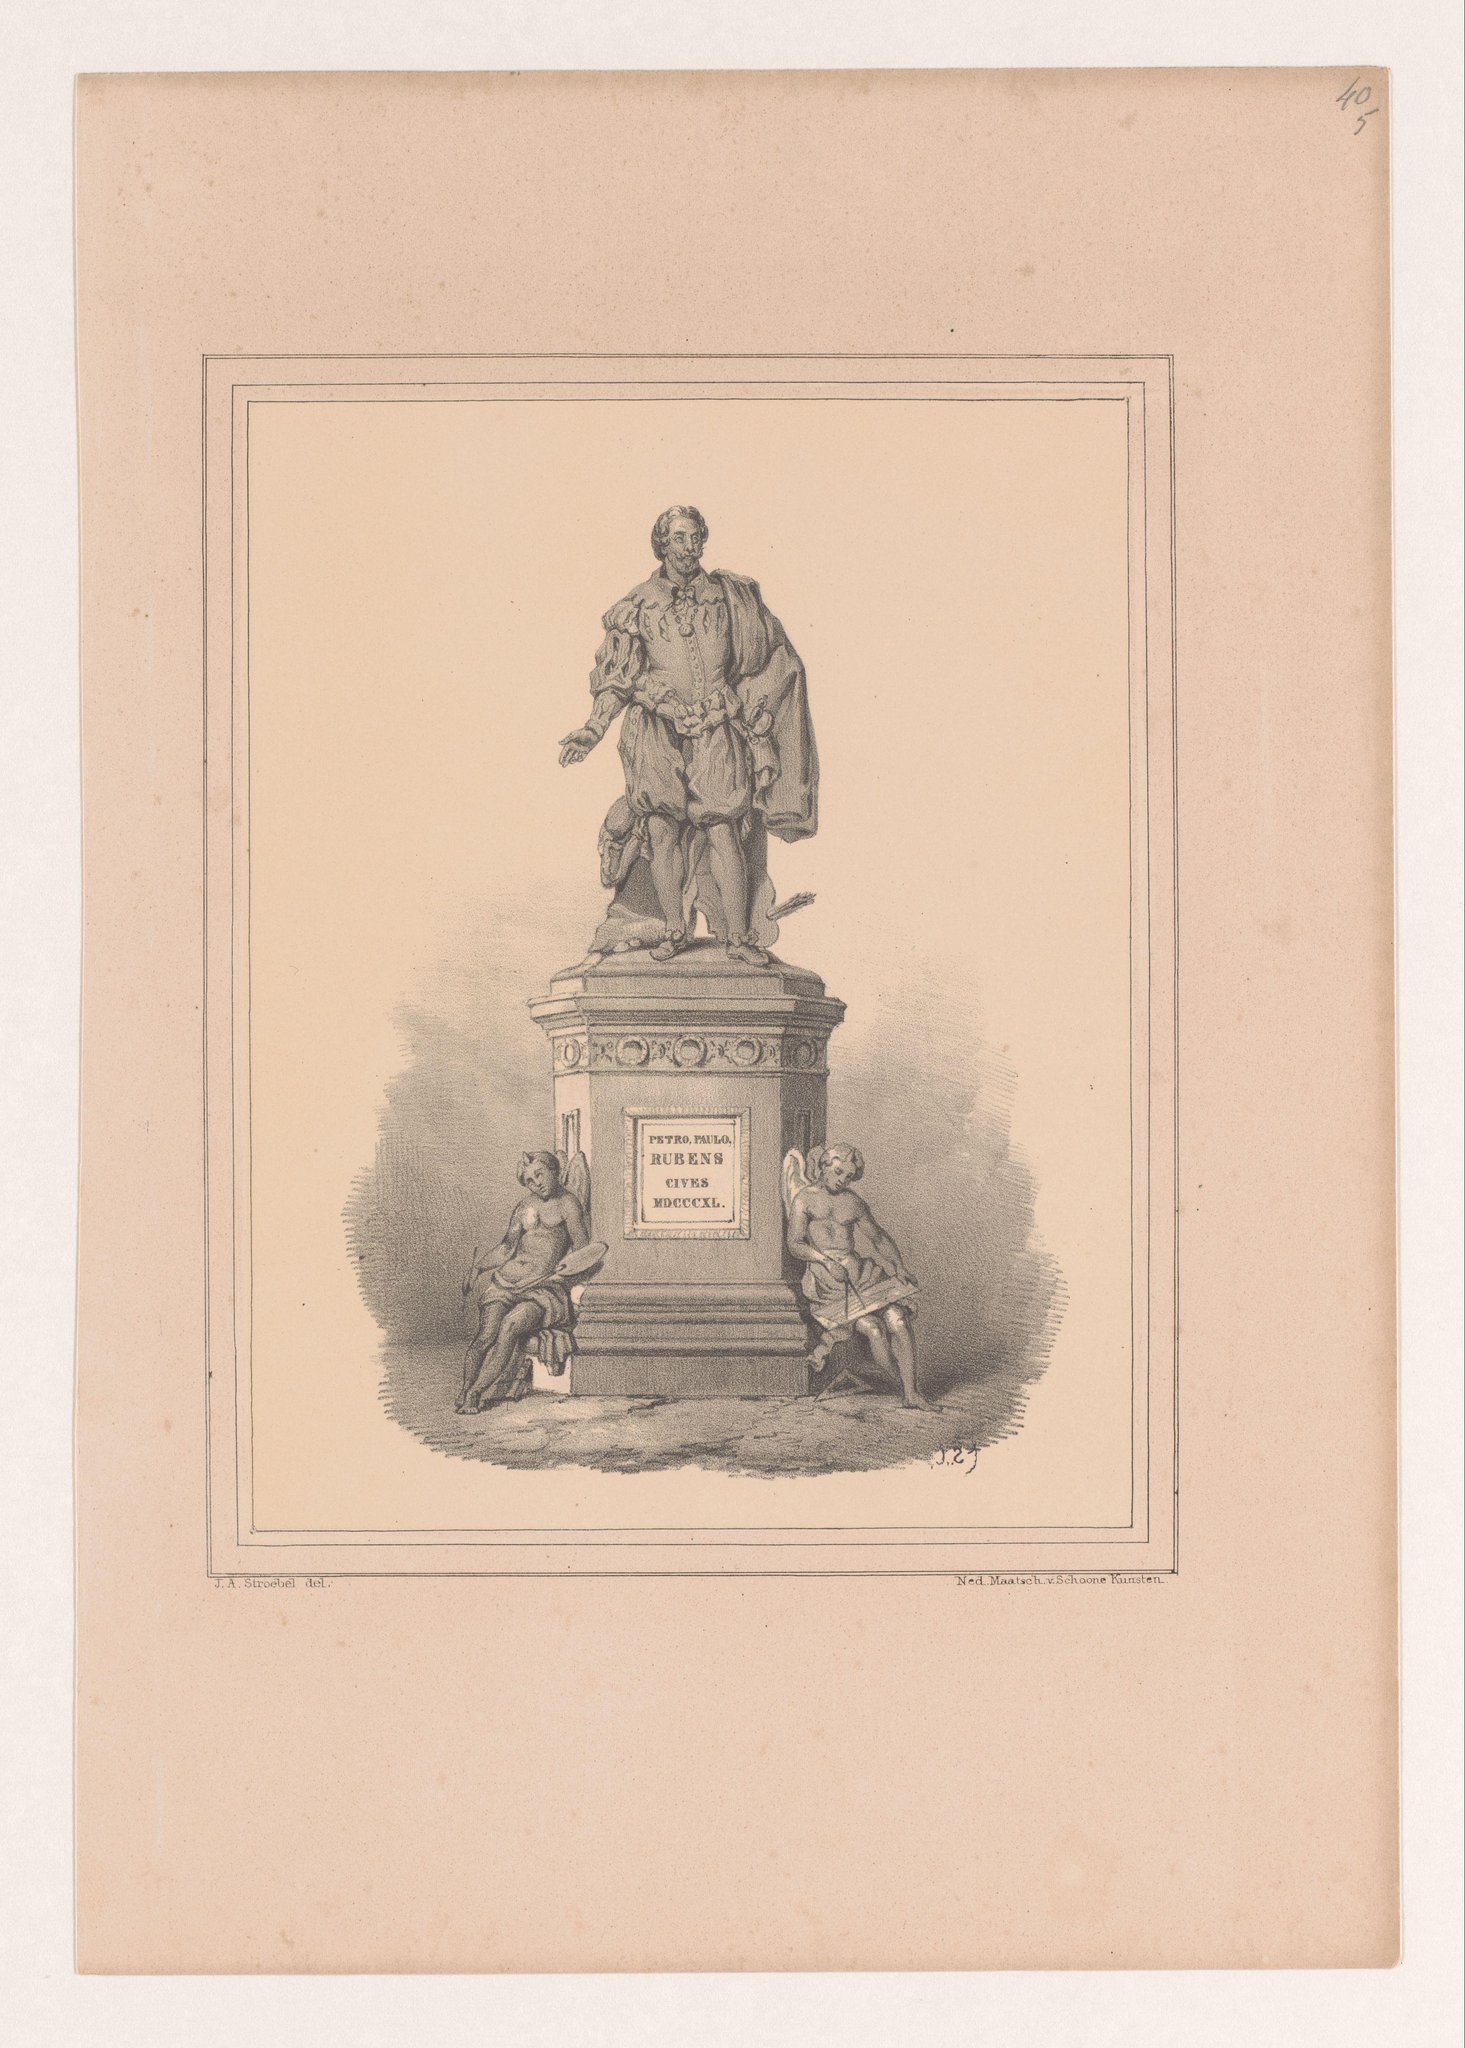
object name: print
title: Standbeeld van Peter Paul Rubens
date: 1840-1843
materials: paper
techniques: tone lithography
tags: antwerp, painter, print maker, draughtsman, peter paul rubens, monument, statue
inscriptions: collector's mark: Lugt 2228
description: De schilder ten voeten uit op een voetstuk, op de Groenplaats te Antwerpen. Aan weerszijden van het voetstuk een personificatie van de kunsten. Opgericht ter ere van de tweehonderdste verjaardag van Rubens' overlijden.